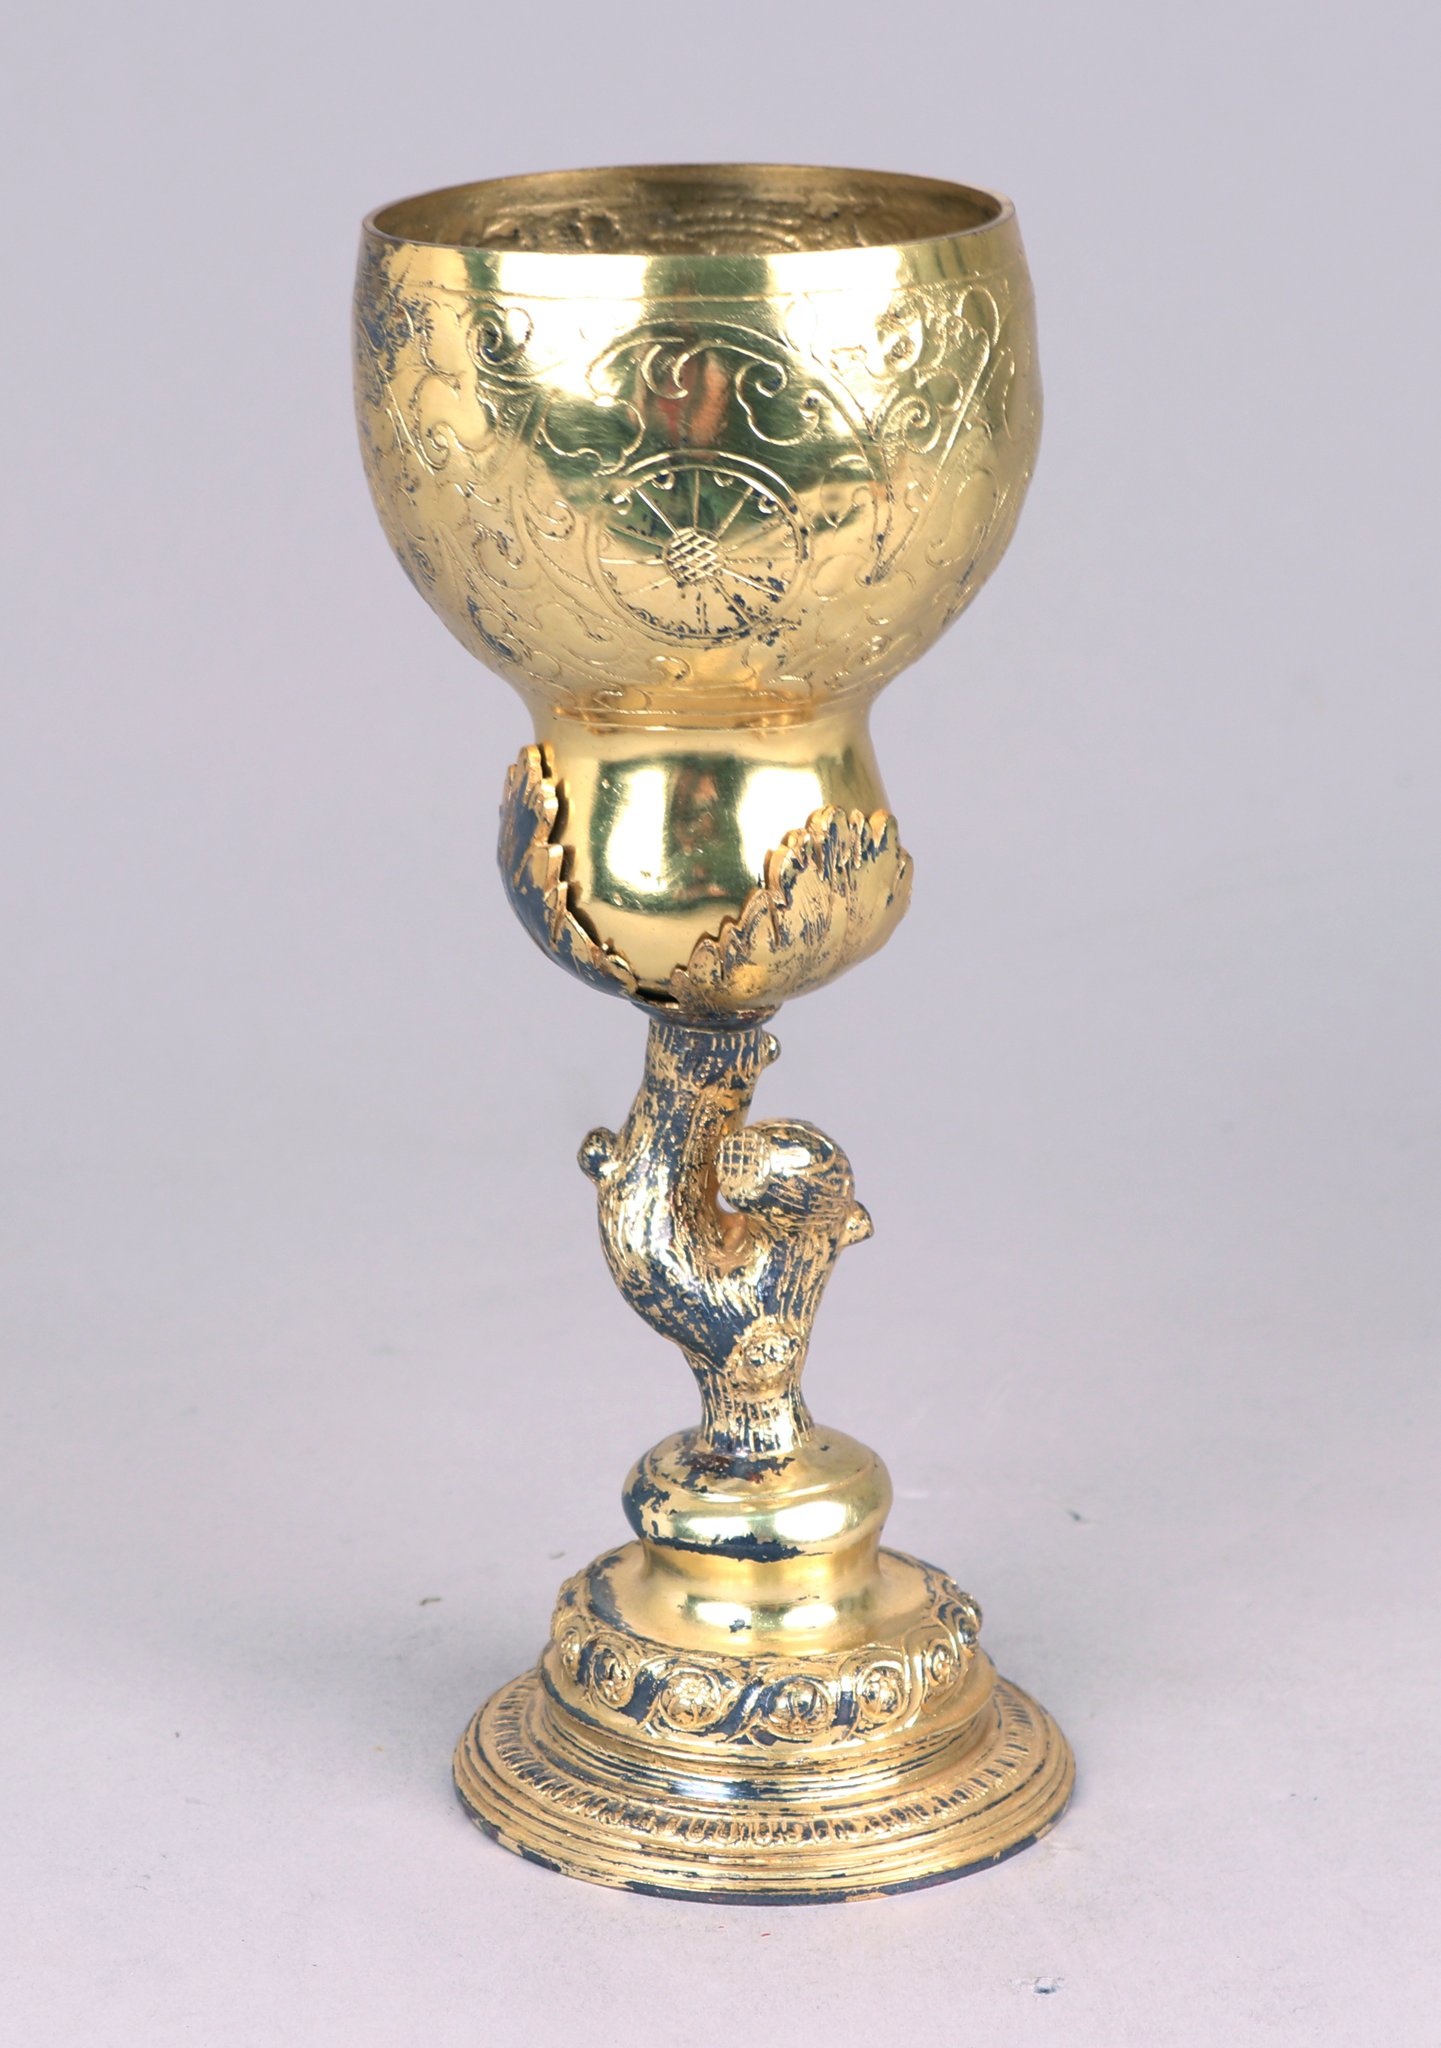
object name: standing cup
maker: elkington & co.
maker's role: manufacturer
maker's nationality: british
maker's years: 1829-1963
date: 1801-1900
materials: metal, silver